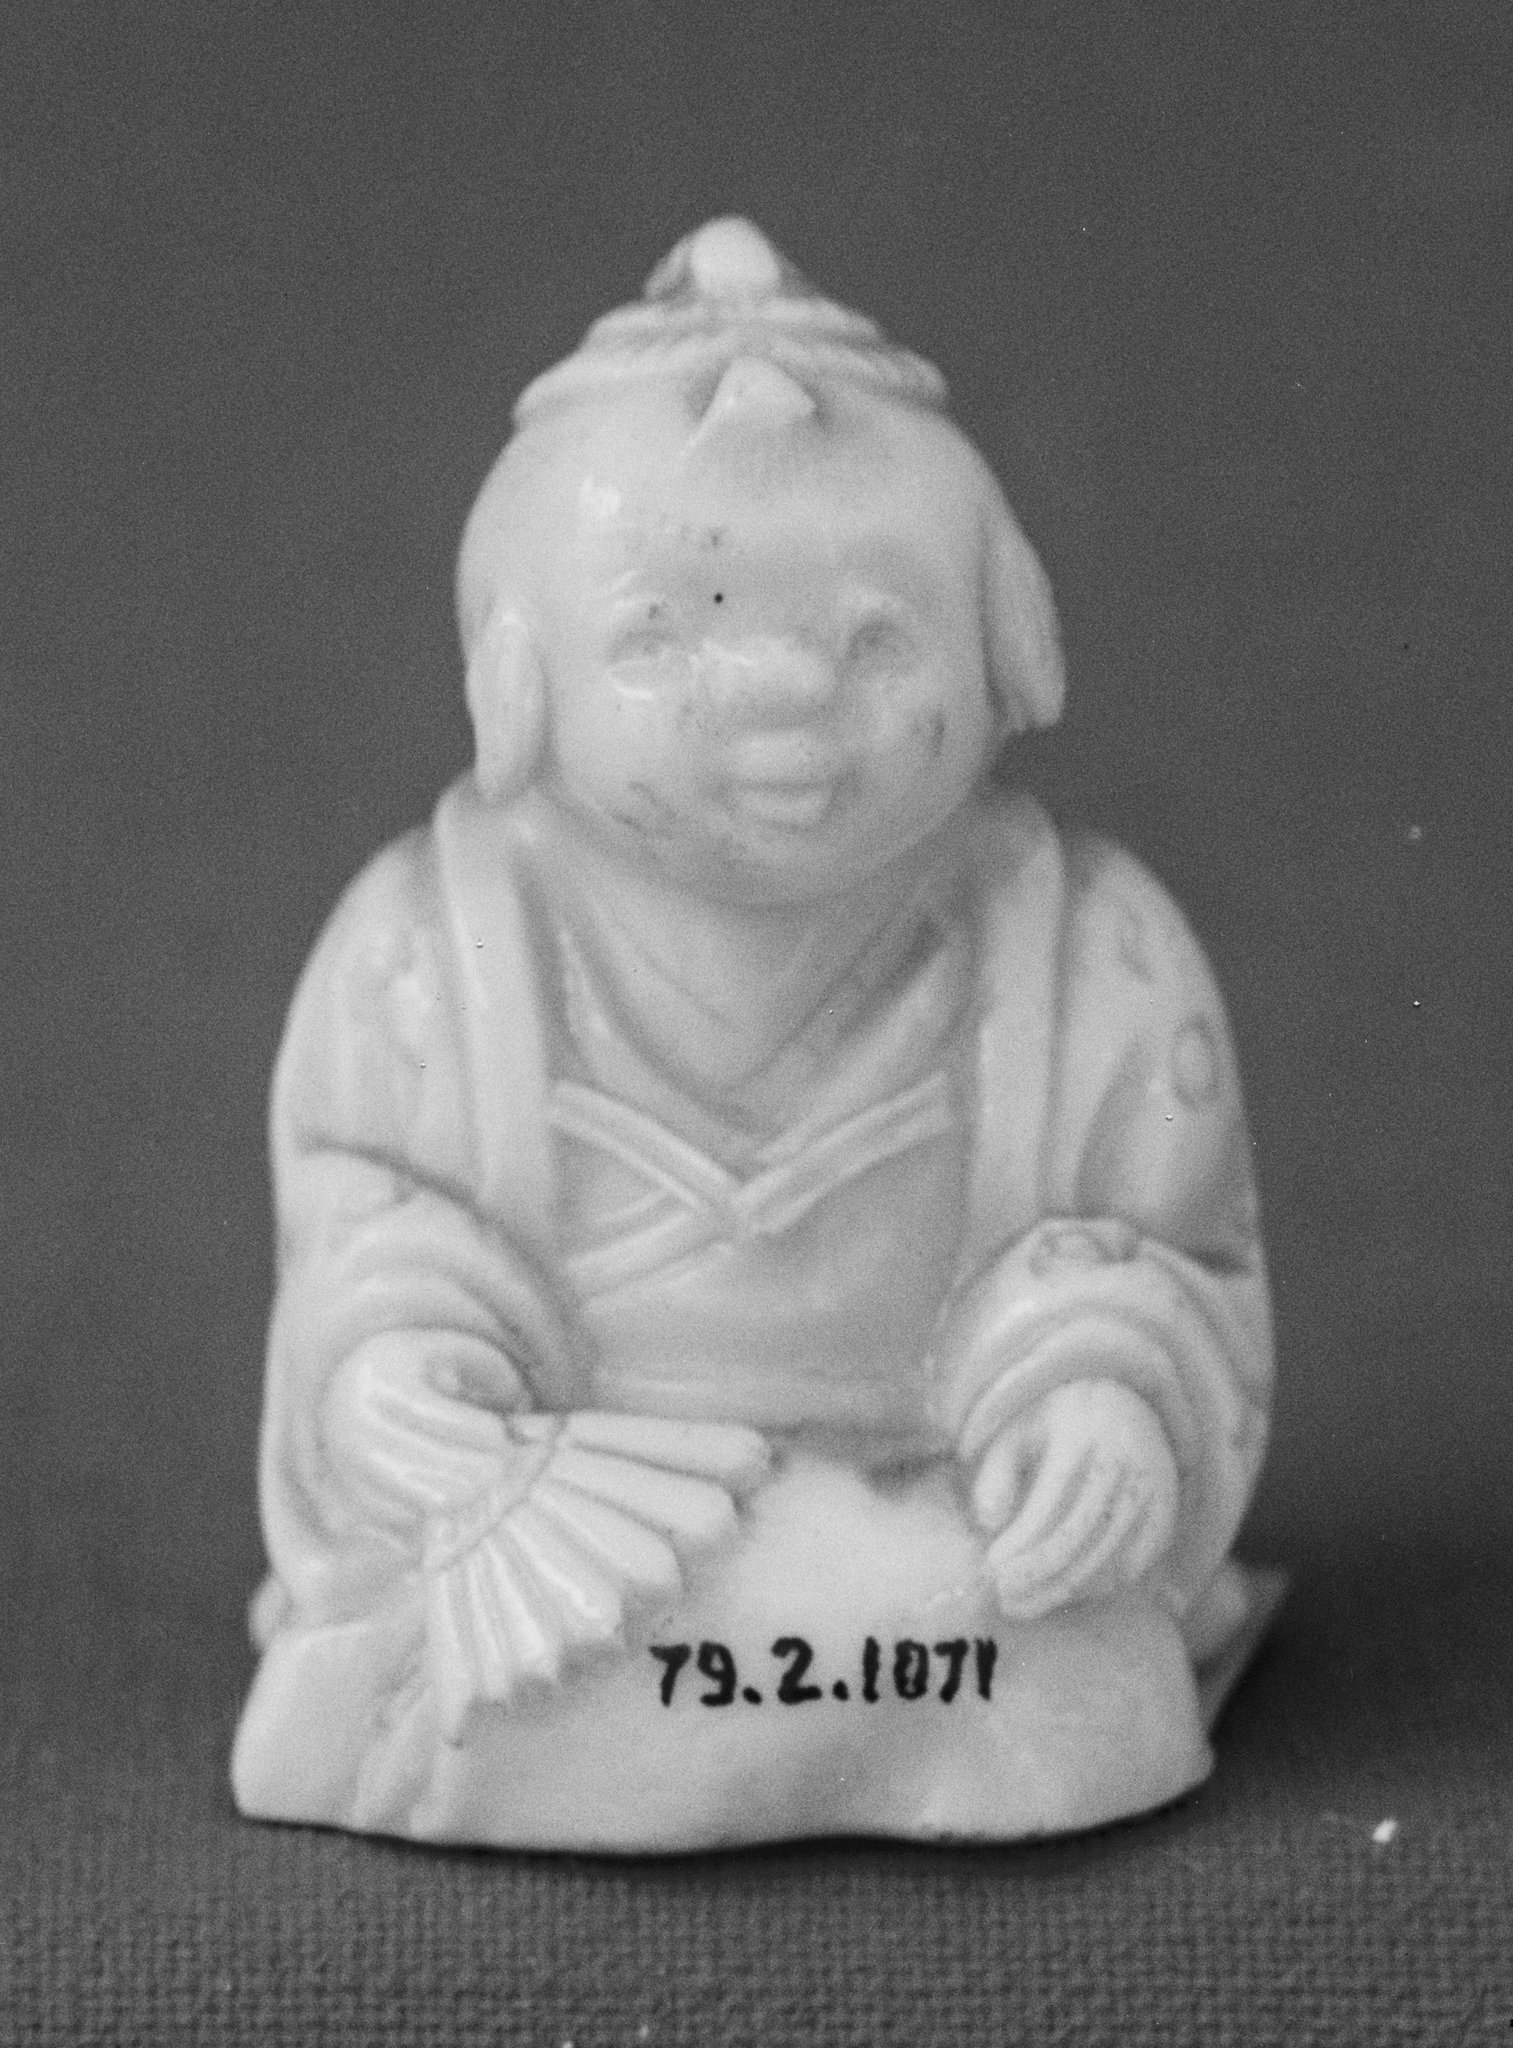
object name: figure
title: Figure of a Child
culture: japanese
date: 1801-1900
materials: porcelain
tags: fans,children